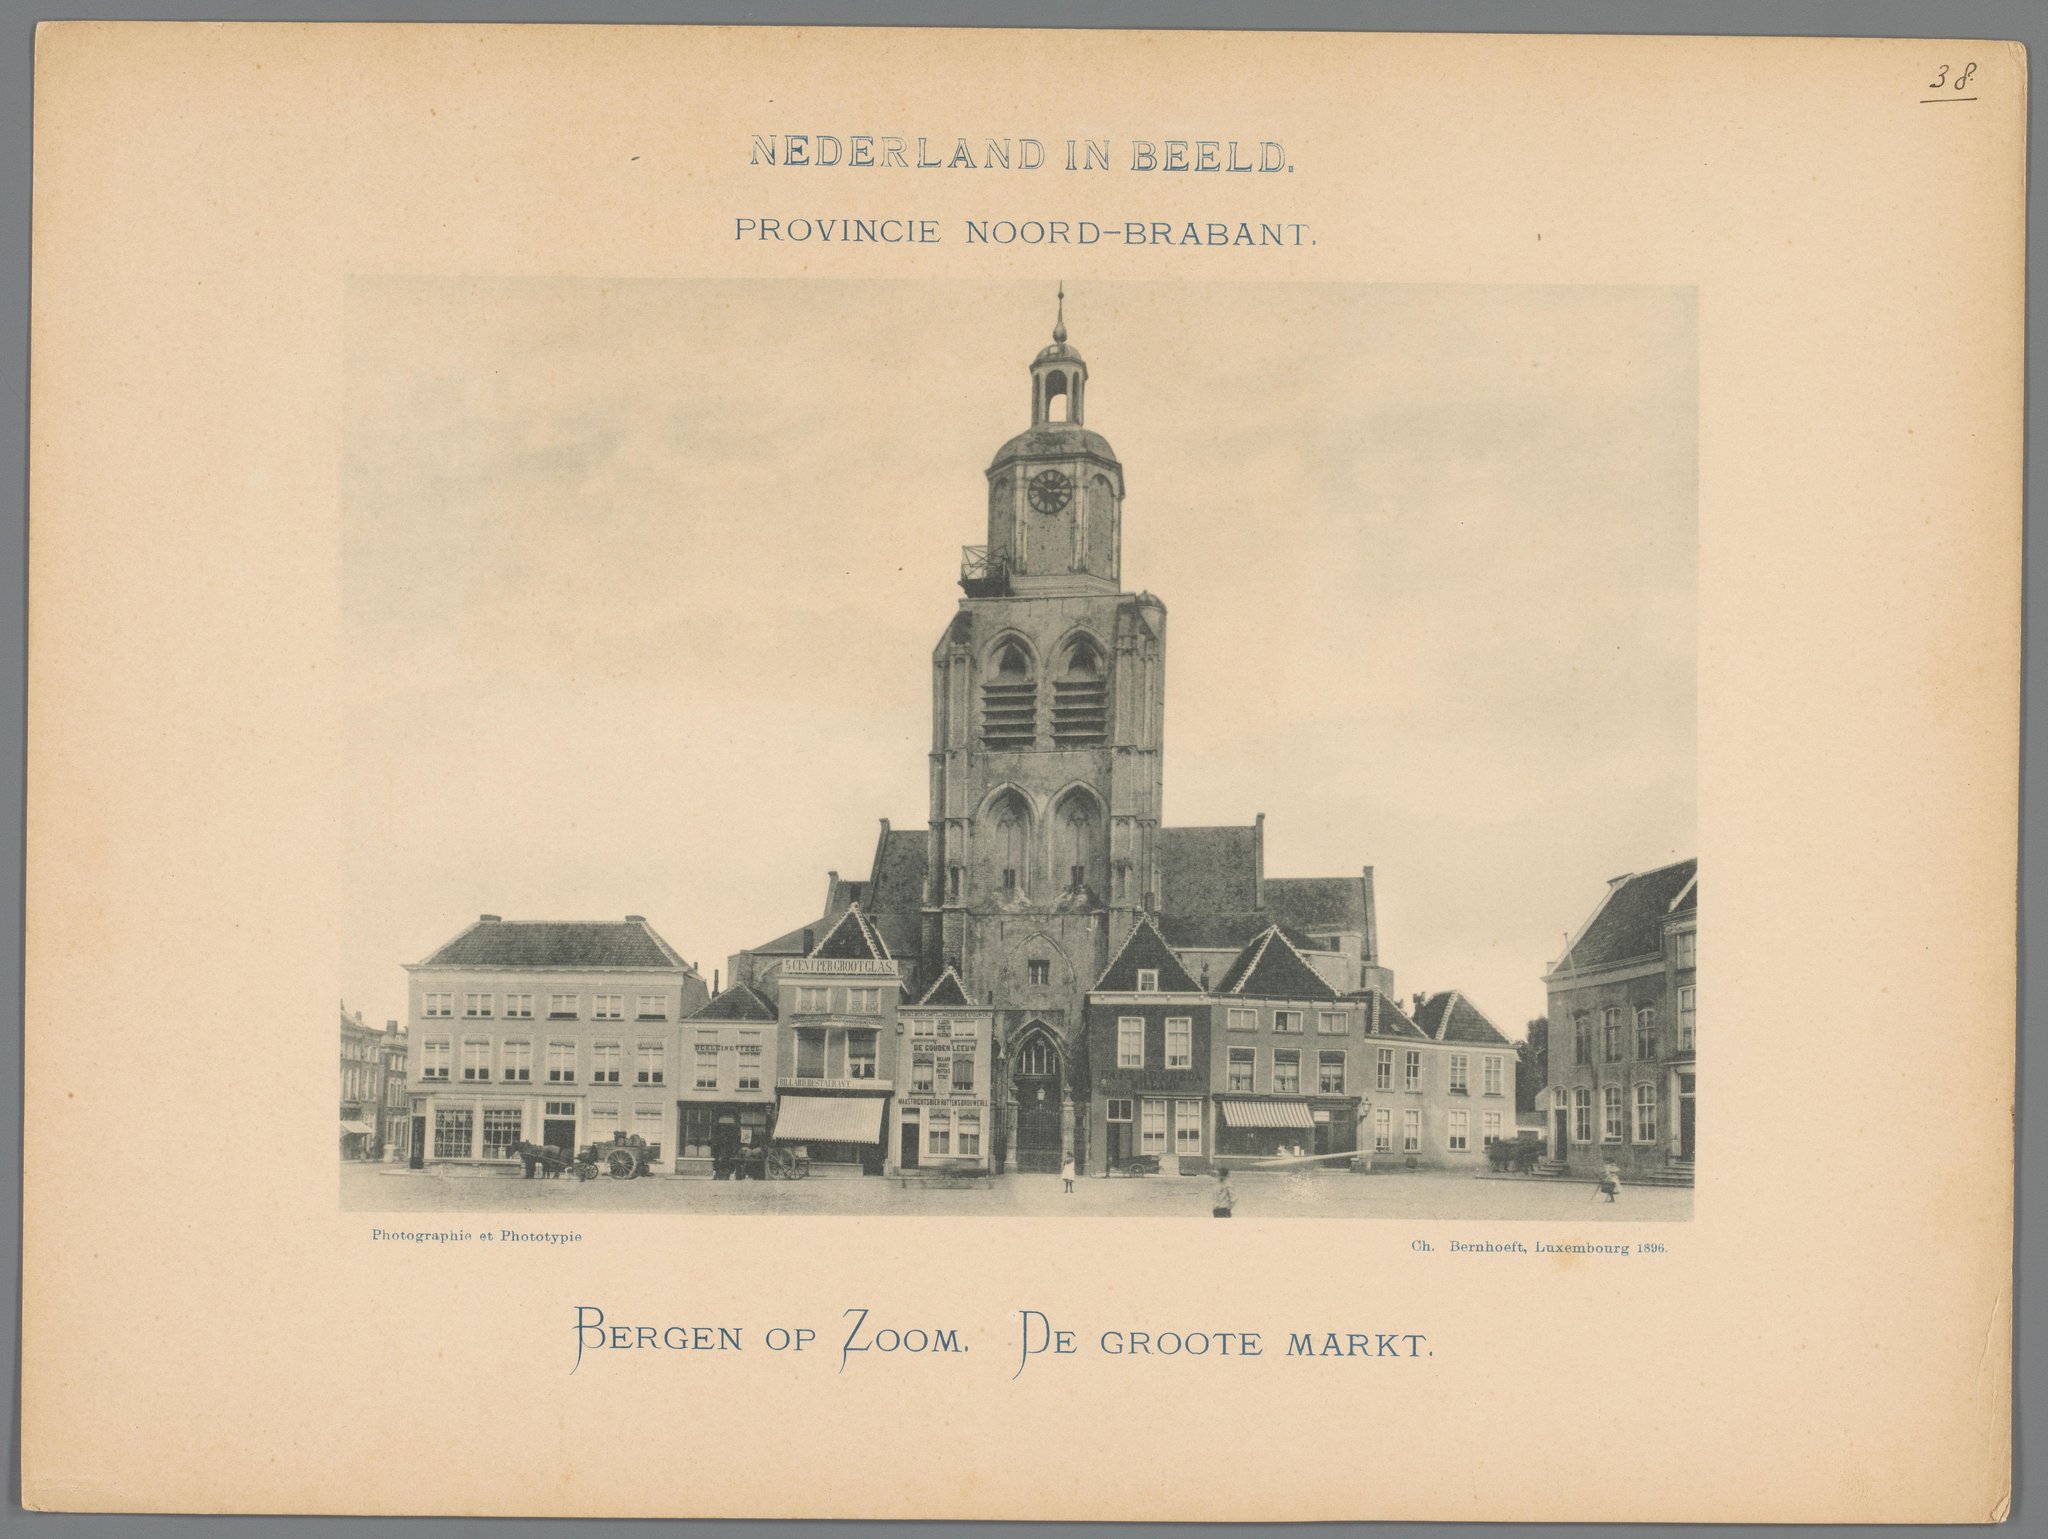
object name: photomechanical print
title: Bergen op Zoom. De Groote Markt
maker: charles bernhoeft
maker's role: publisher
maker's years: 1859-1933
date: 1896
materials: paper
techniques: photograph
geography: bergen op zoom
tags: urban housing, church (exterior), bergen op zoom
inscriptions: number: ‘38.’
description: Deze prent maakt deel uit van een omslag met 43 lichtdrukken op 43 bladen.